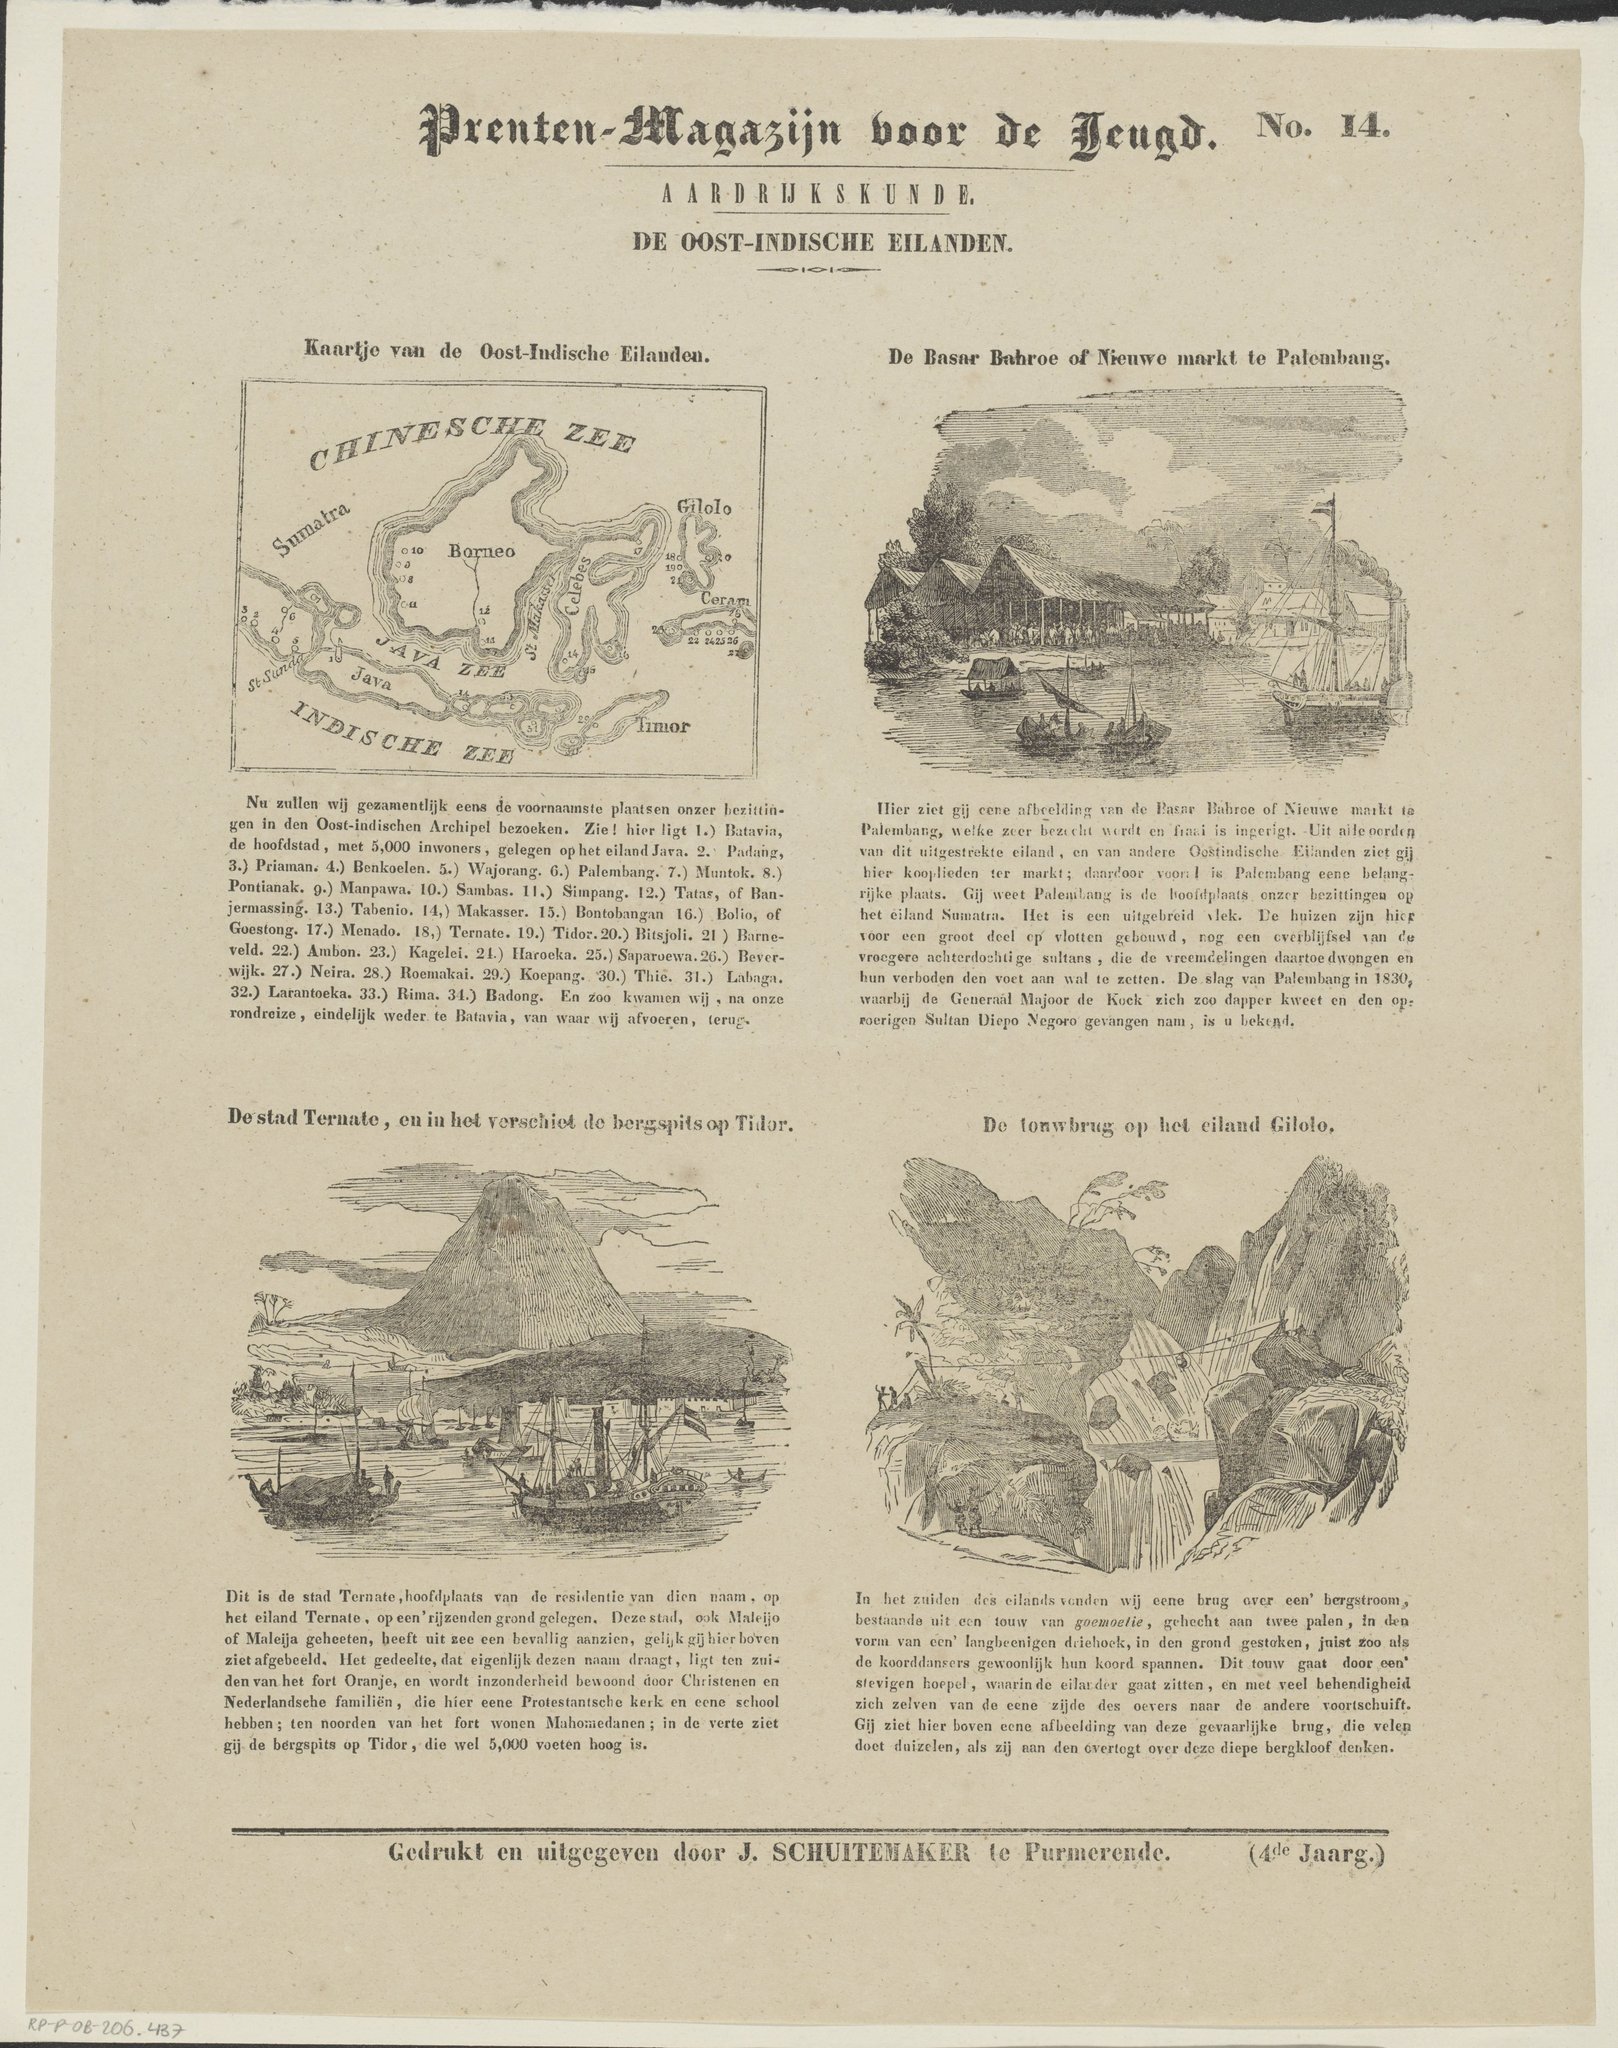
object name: print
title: Prenten-magazijn voor de jeugd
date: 1845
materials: paper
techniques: letterpress printing, engraving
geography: netherlands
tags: colonial system, maps, atlases, landscape with bridge, viaduct or aqueduct, market, volcano, palembang (city), indonesian archipelago, dutch east indies, the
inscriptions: collector's mark: Lugt 2760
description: Blad met vier voorstellingen van eilanden in de Indonesische archipel: een kaart, de Nieuwe Markt te Palembang, de stad Ternate en de touwbrug in Halmahera. Boven elke voorstelling een titel en onder elke voorstelling een onderschrift. Genummerd rechtsboven: No. 14.